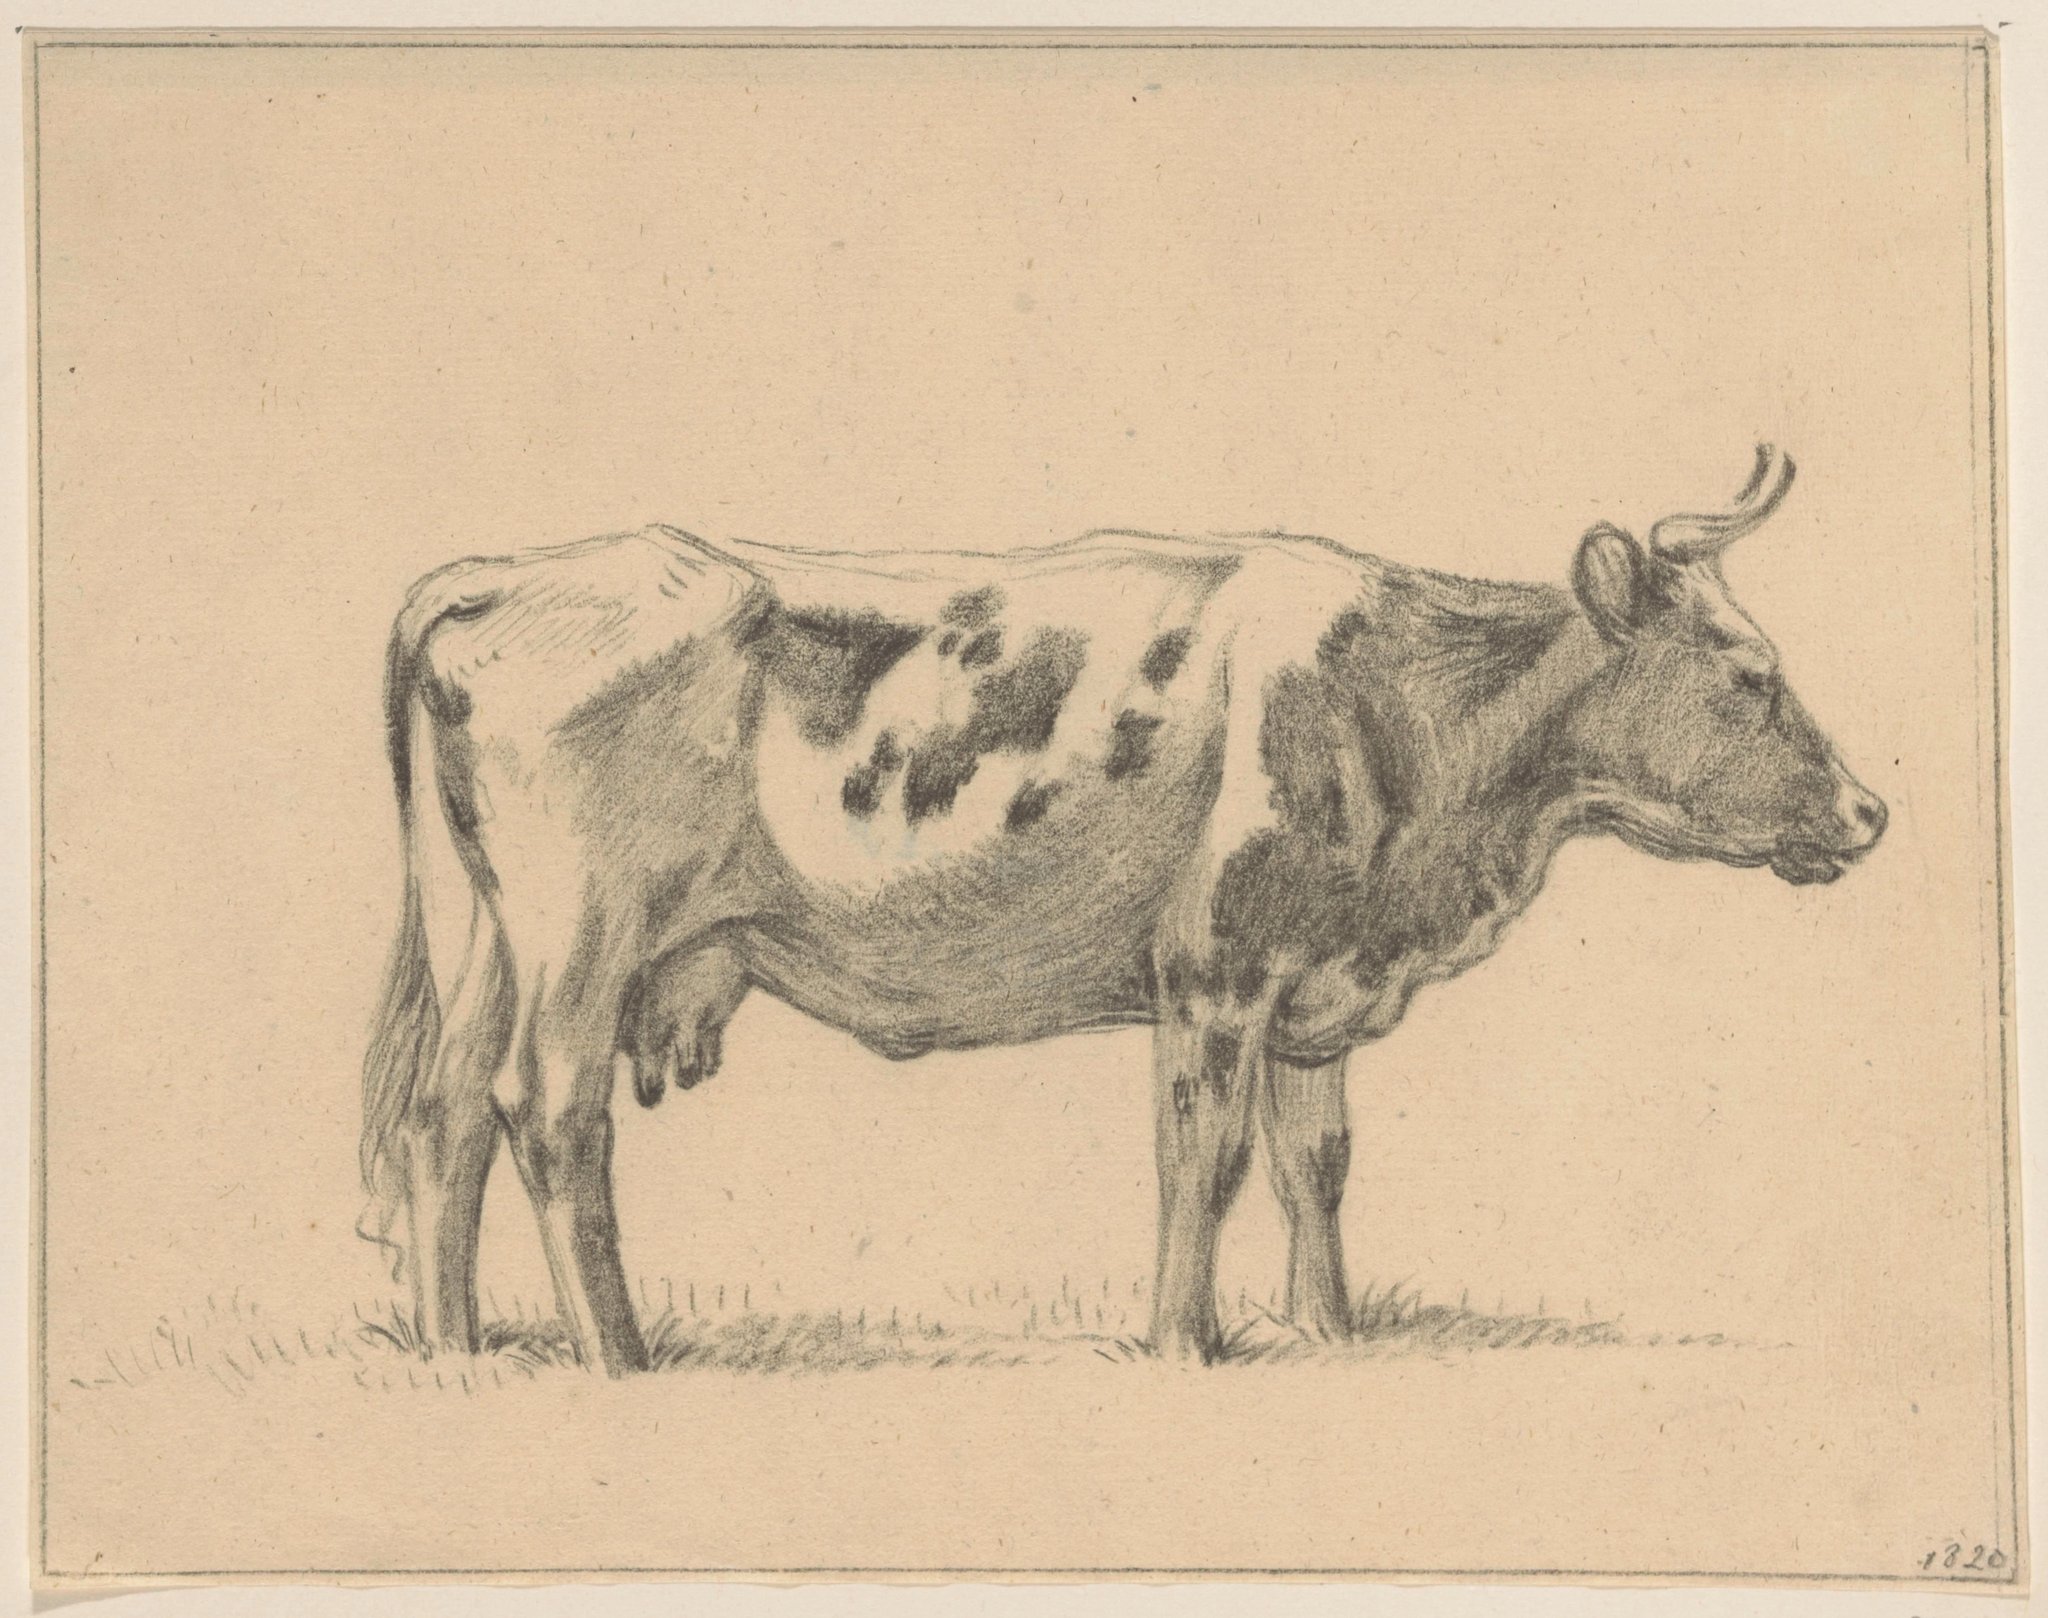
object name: drawing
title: Staande koe, naar rechts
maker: jean bernard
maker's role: draughtsman, print maker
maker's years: 1765-1833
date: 1820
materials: chalk, paper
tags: cow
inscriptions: date: ‘1820’